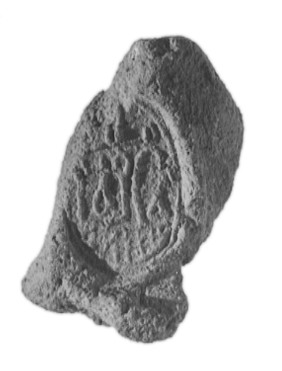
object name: sealing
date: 2030-1640 BCE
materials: clay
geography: egypt